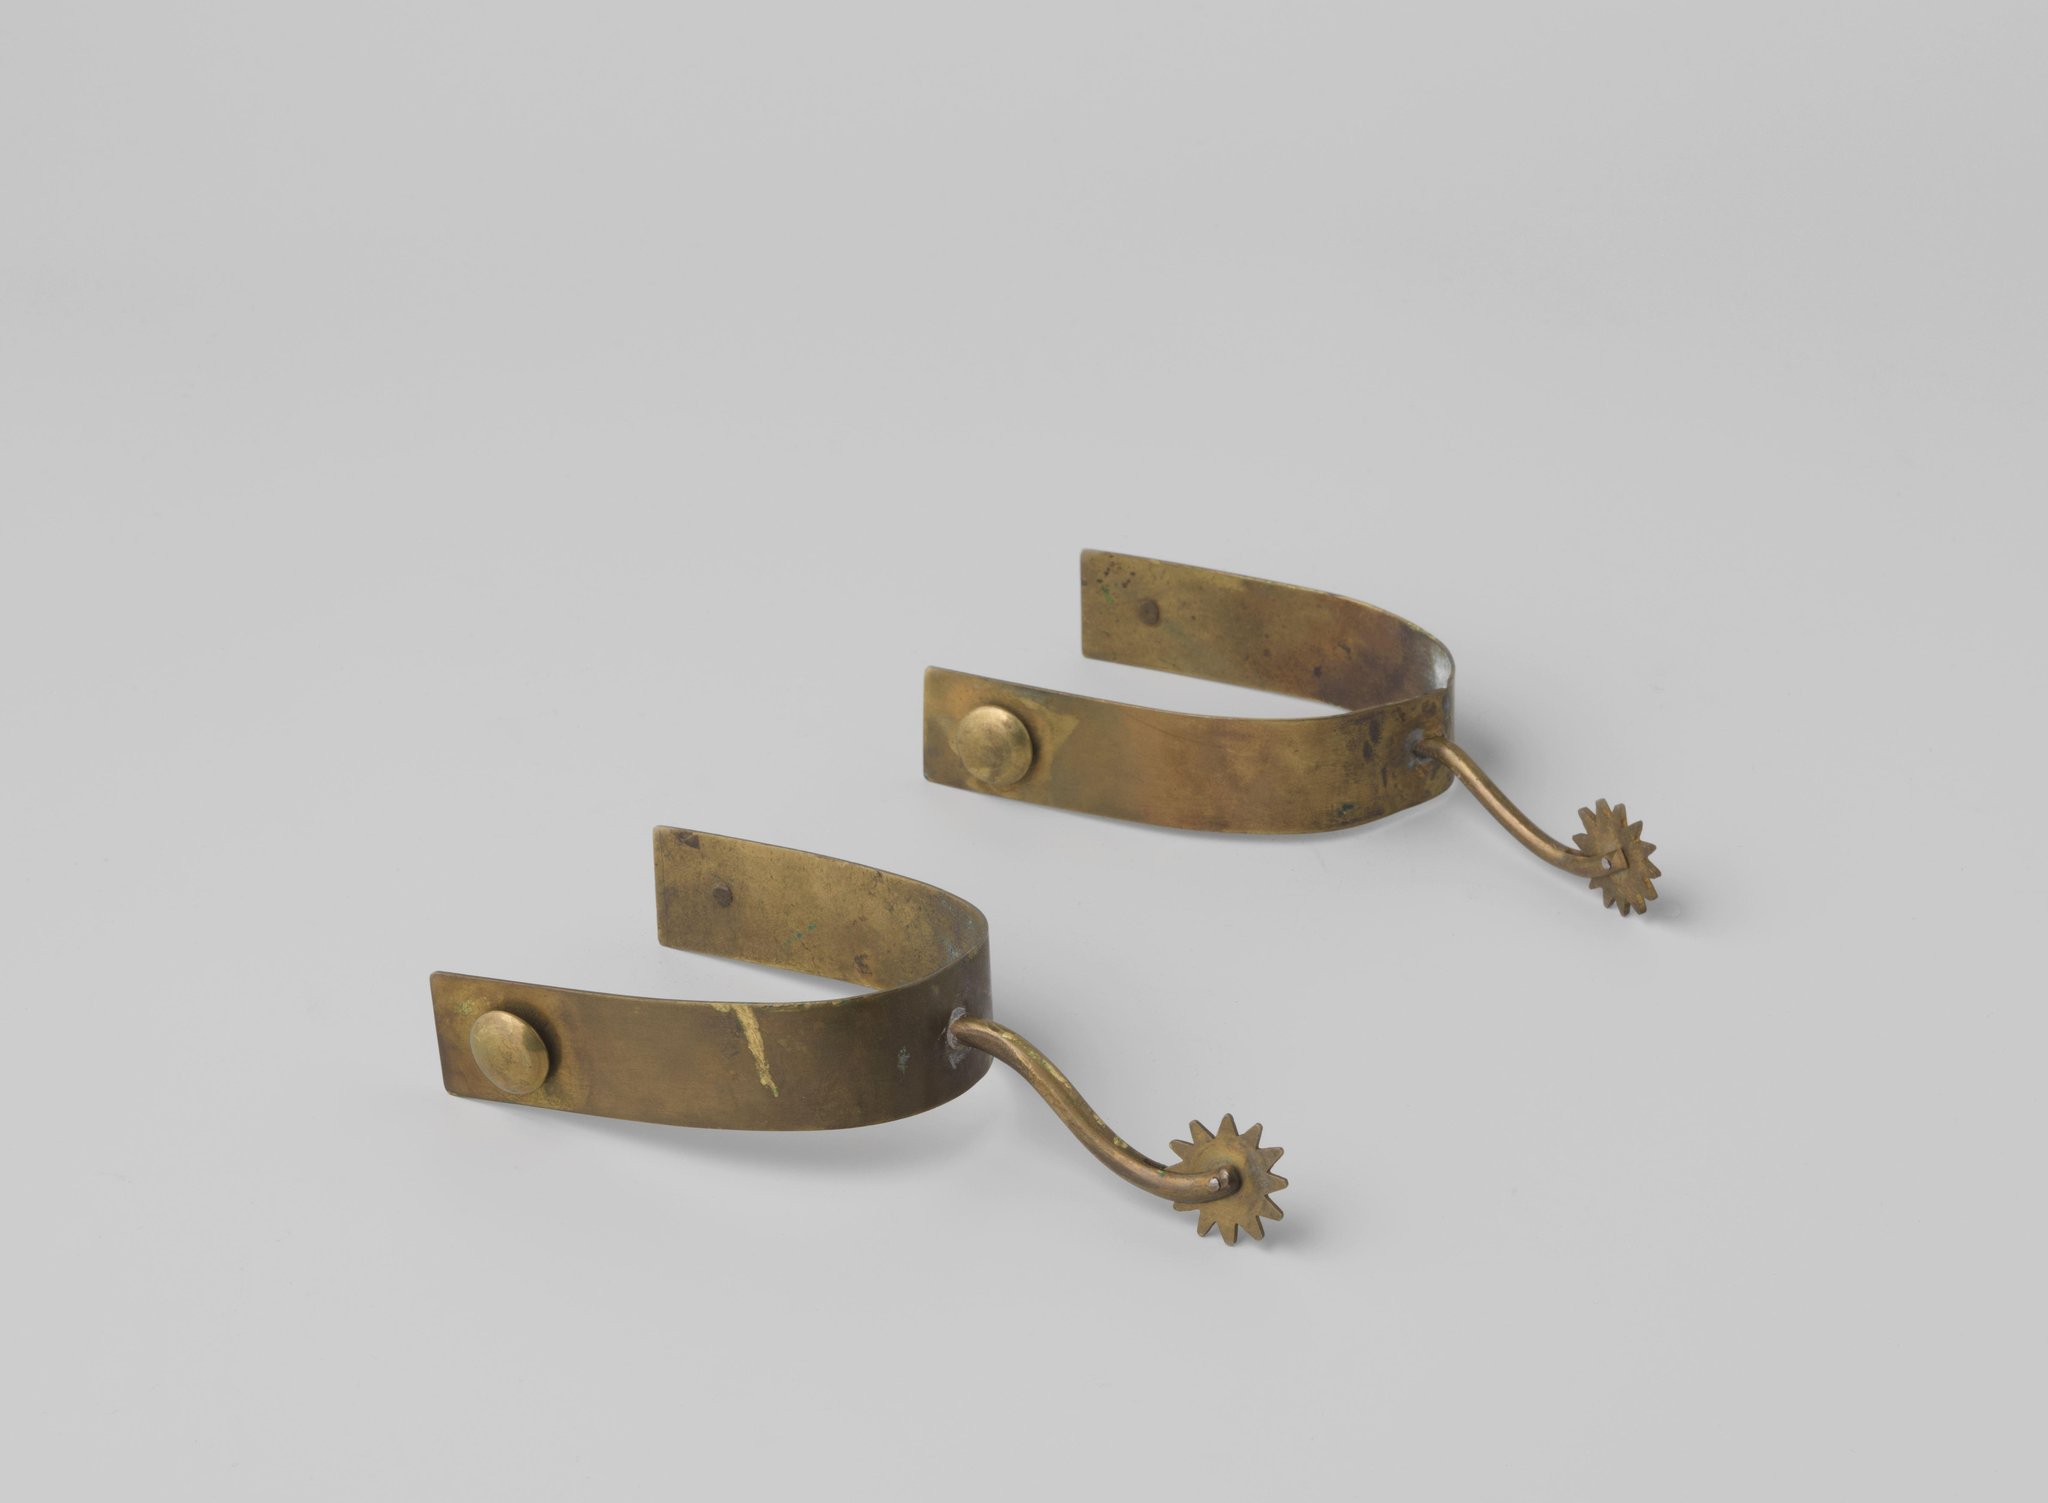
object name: spoor objectnaam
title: Spoor, bestaande uit een u-vormige band van koper, waaraan een staaf met tandwiel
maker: Anonymous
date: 1913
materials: copper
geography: delft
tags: delft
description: Spoor, bestaande uit een u-vormige band van koper, waaraan een staaf met tandwiel.